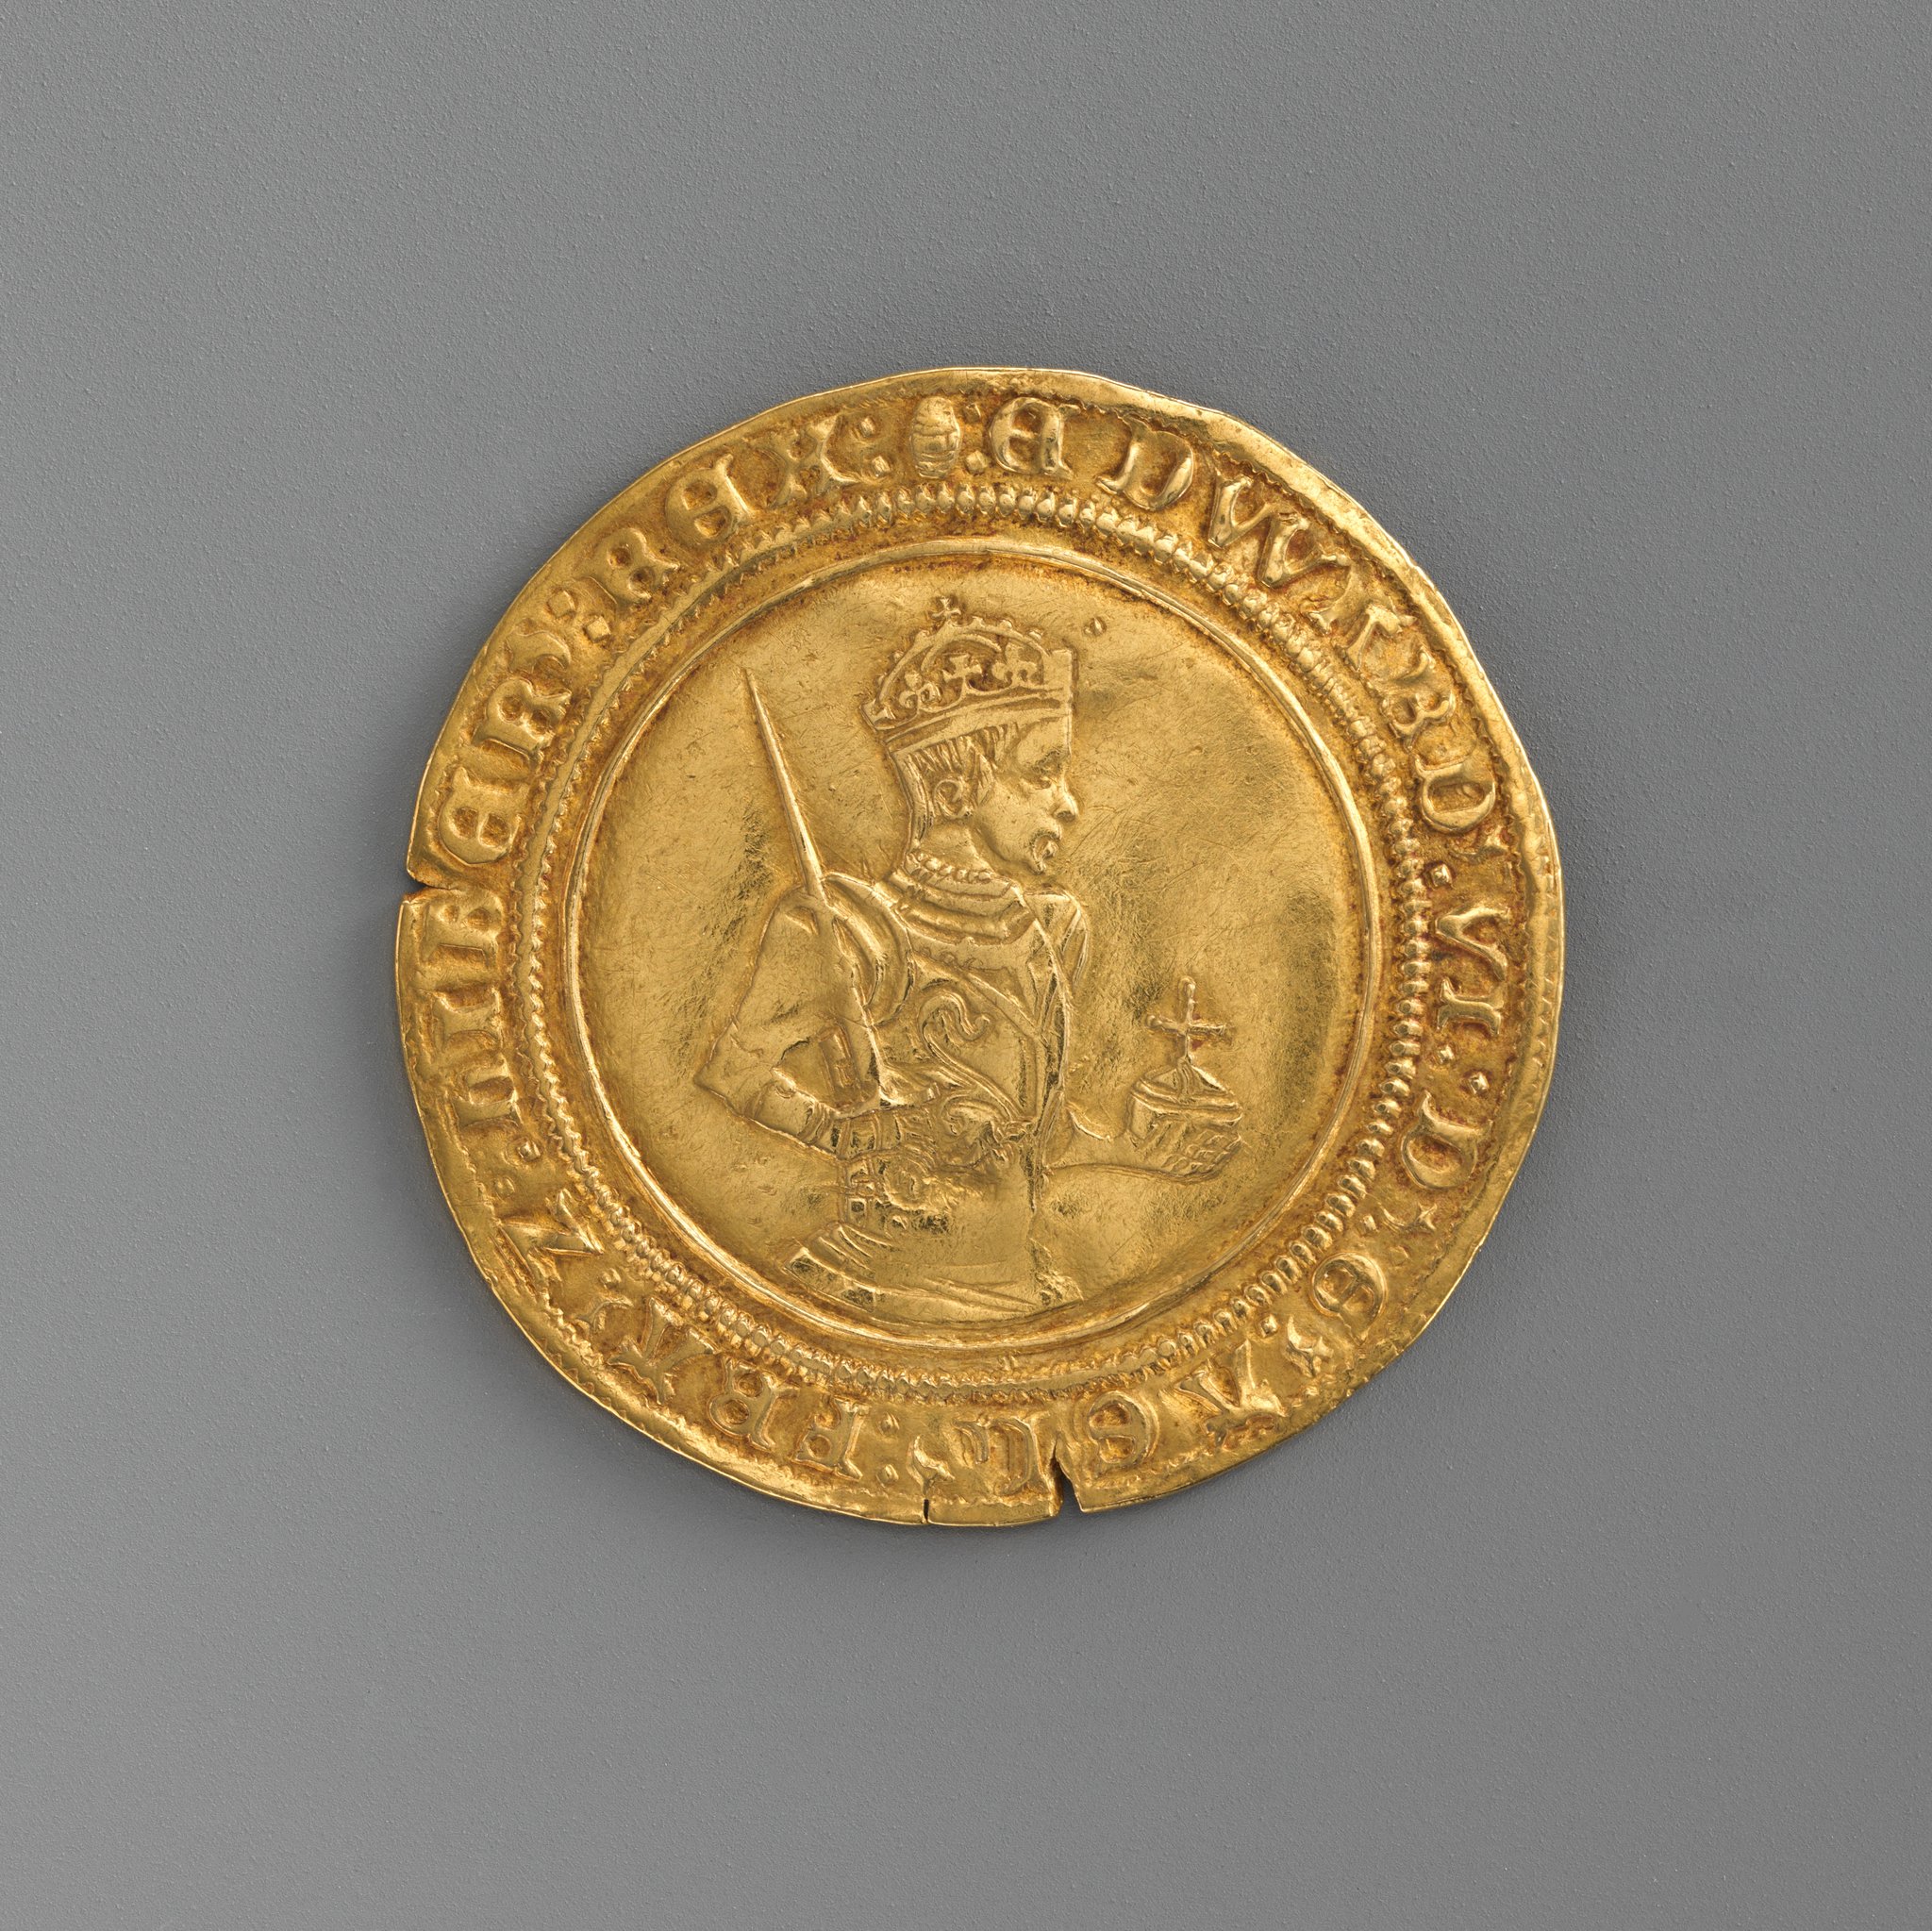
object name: sovereign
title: Edward VI (r. 1547–53)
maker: the royal mint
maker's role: manufactory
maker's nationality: british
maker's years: 886-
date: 1552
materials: gold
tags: men,profiles,coins,coat of arms